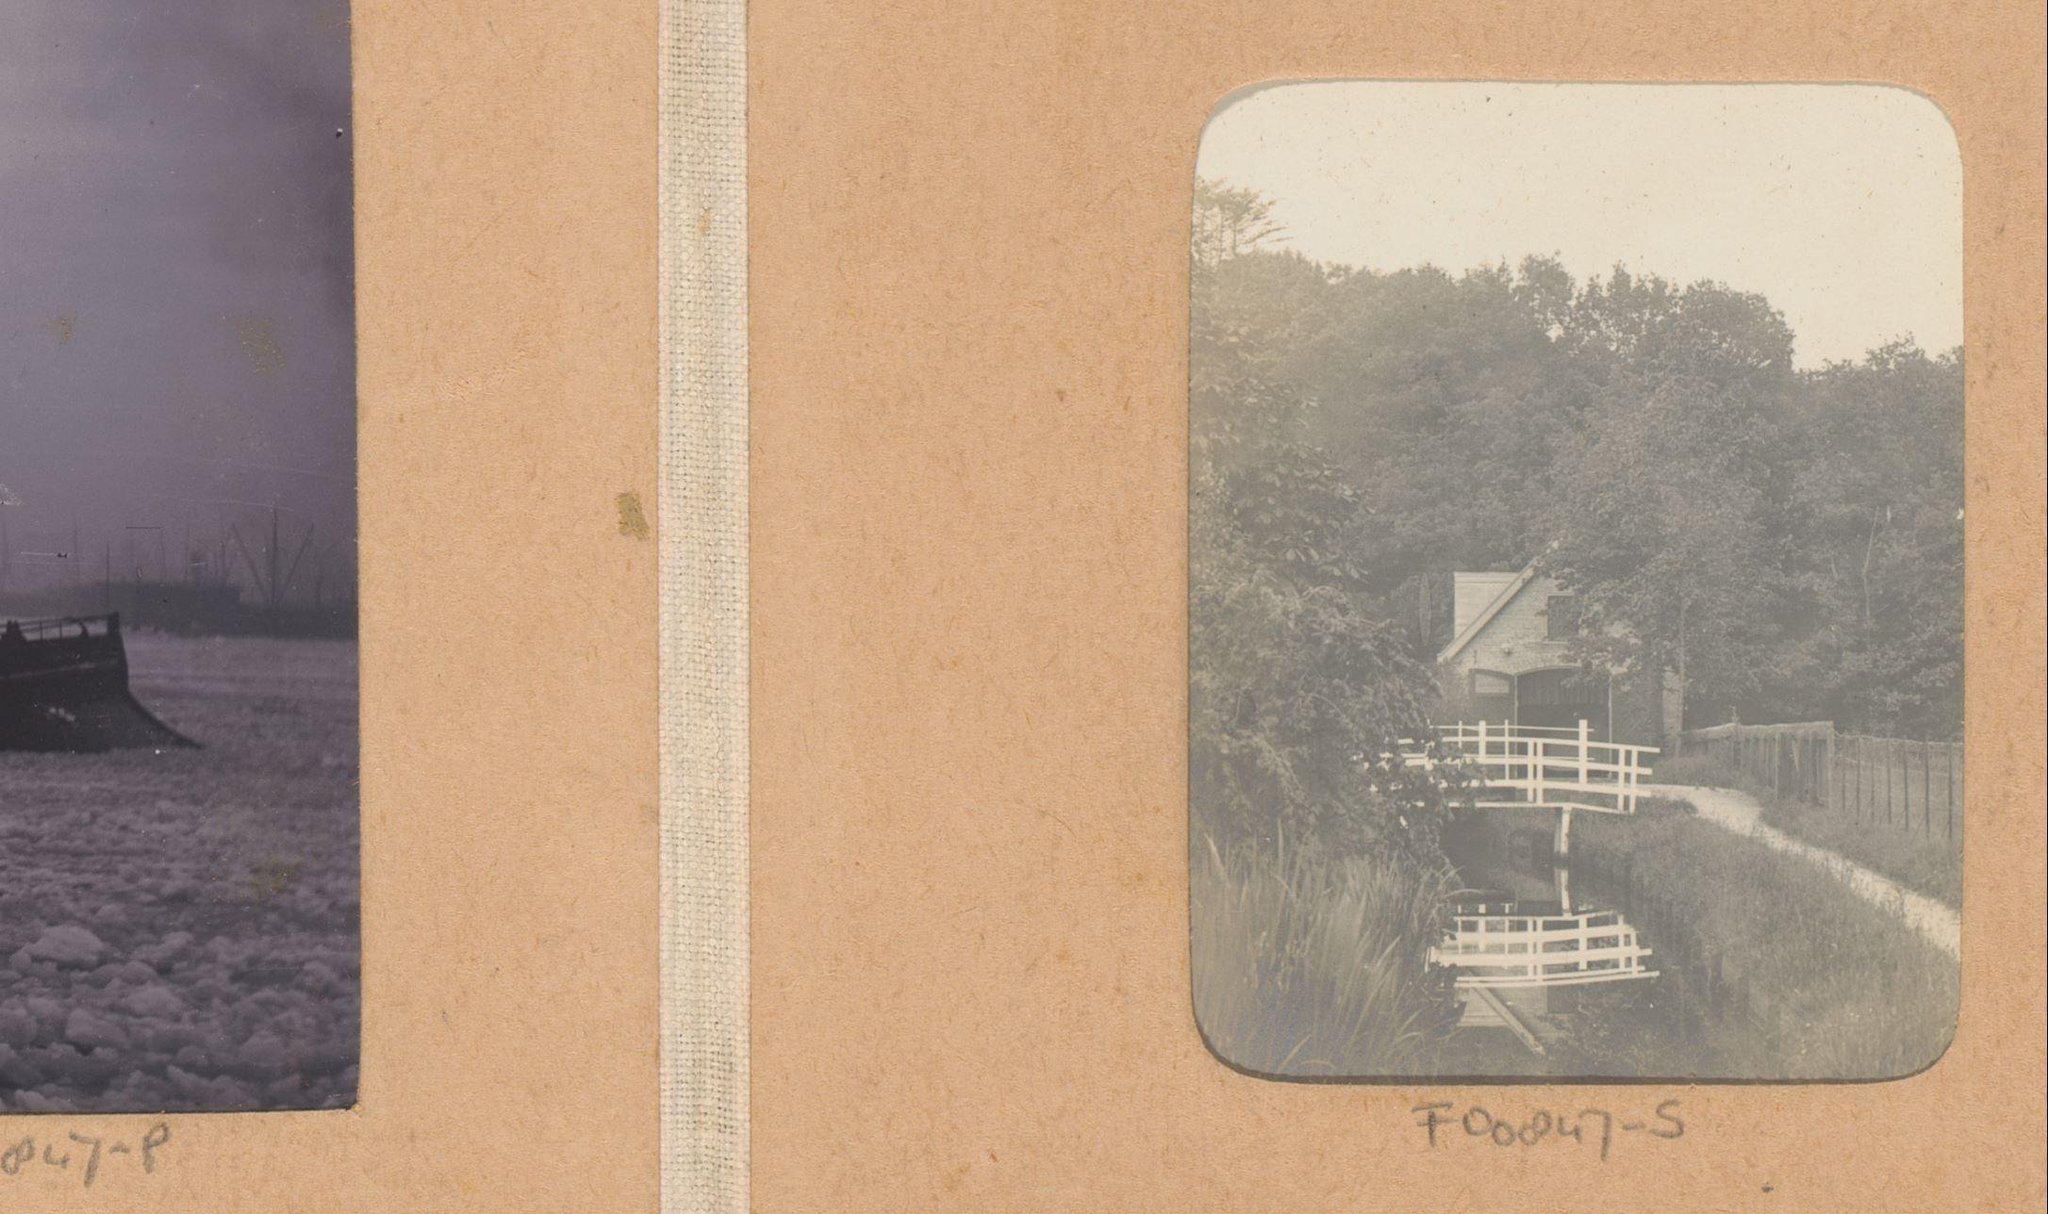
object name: photograph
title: Sloot met brug bij een huis, vermoedelijk in Nederland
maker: Anonymous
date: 1902-1906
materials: cardboard, paper, photographic support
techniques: gelatin silver print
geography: netherlands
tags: landscape with bridge, viaduct or aqueduct, rural housing, e.g. country-house, villa, cottage, road, path, small canal, ditch, netherlands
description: Onderdeel van Reisalbum van een Nederlandse familie met bezienswaardigheden in Europa, Egypte en New York.